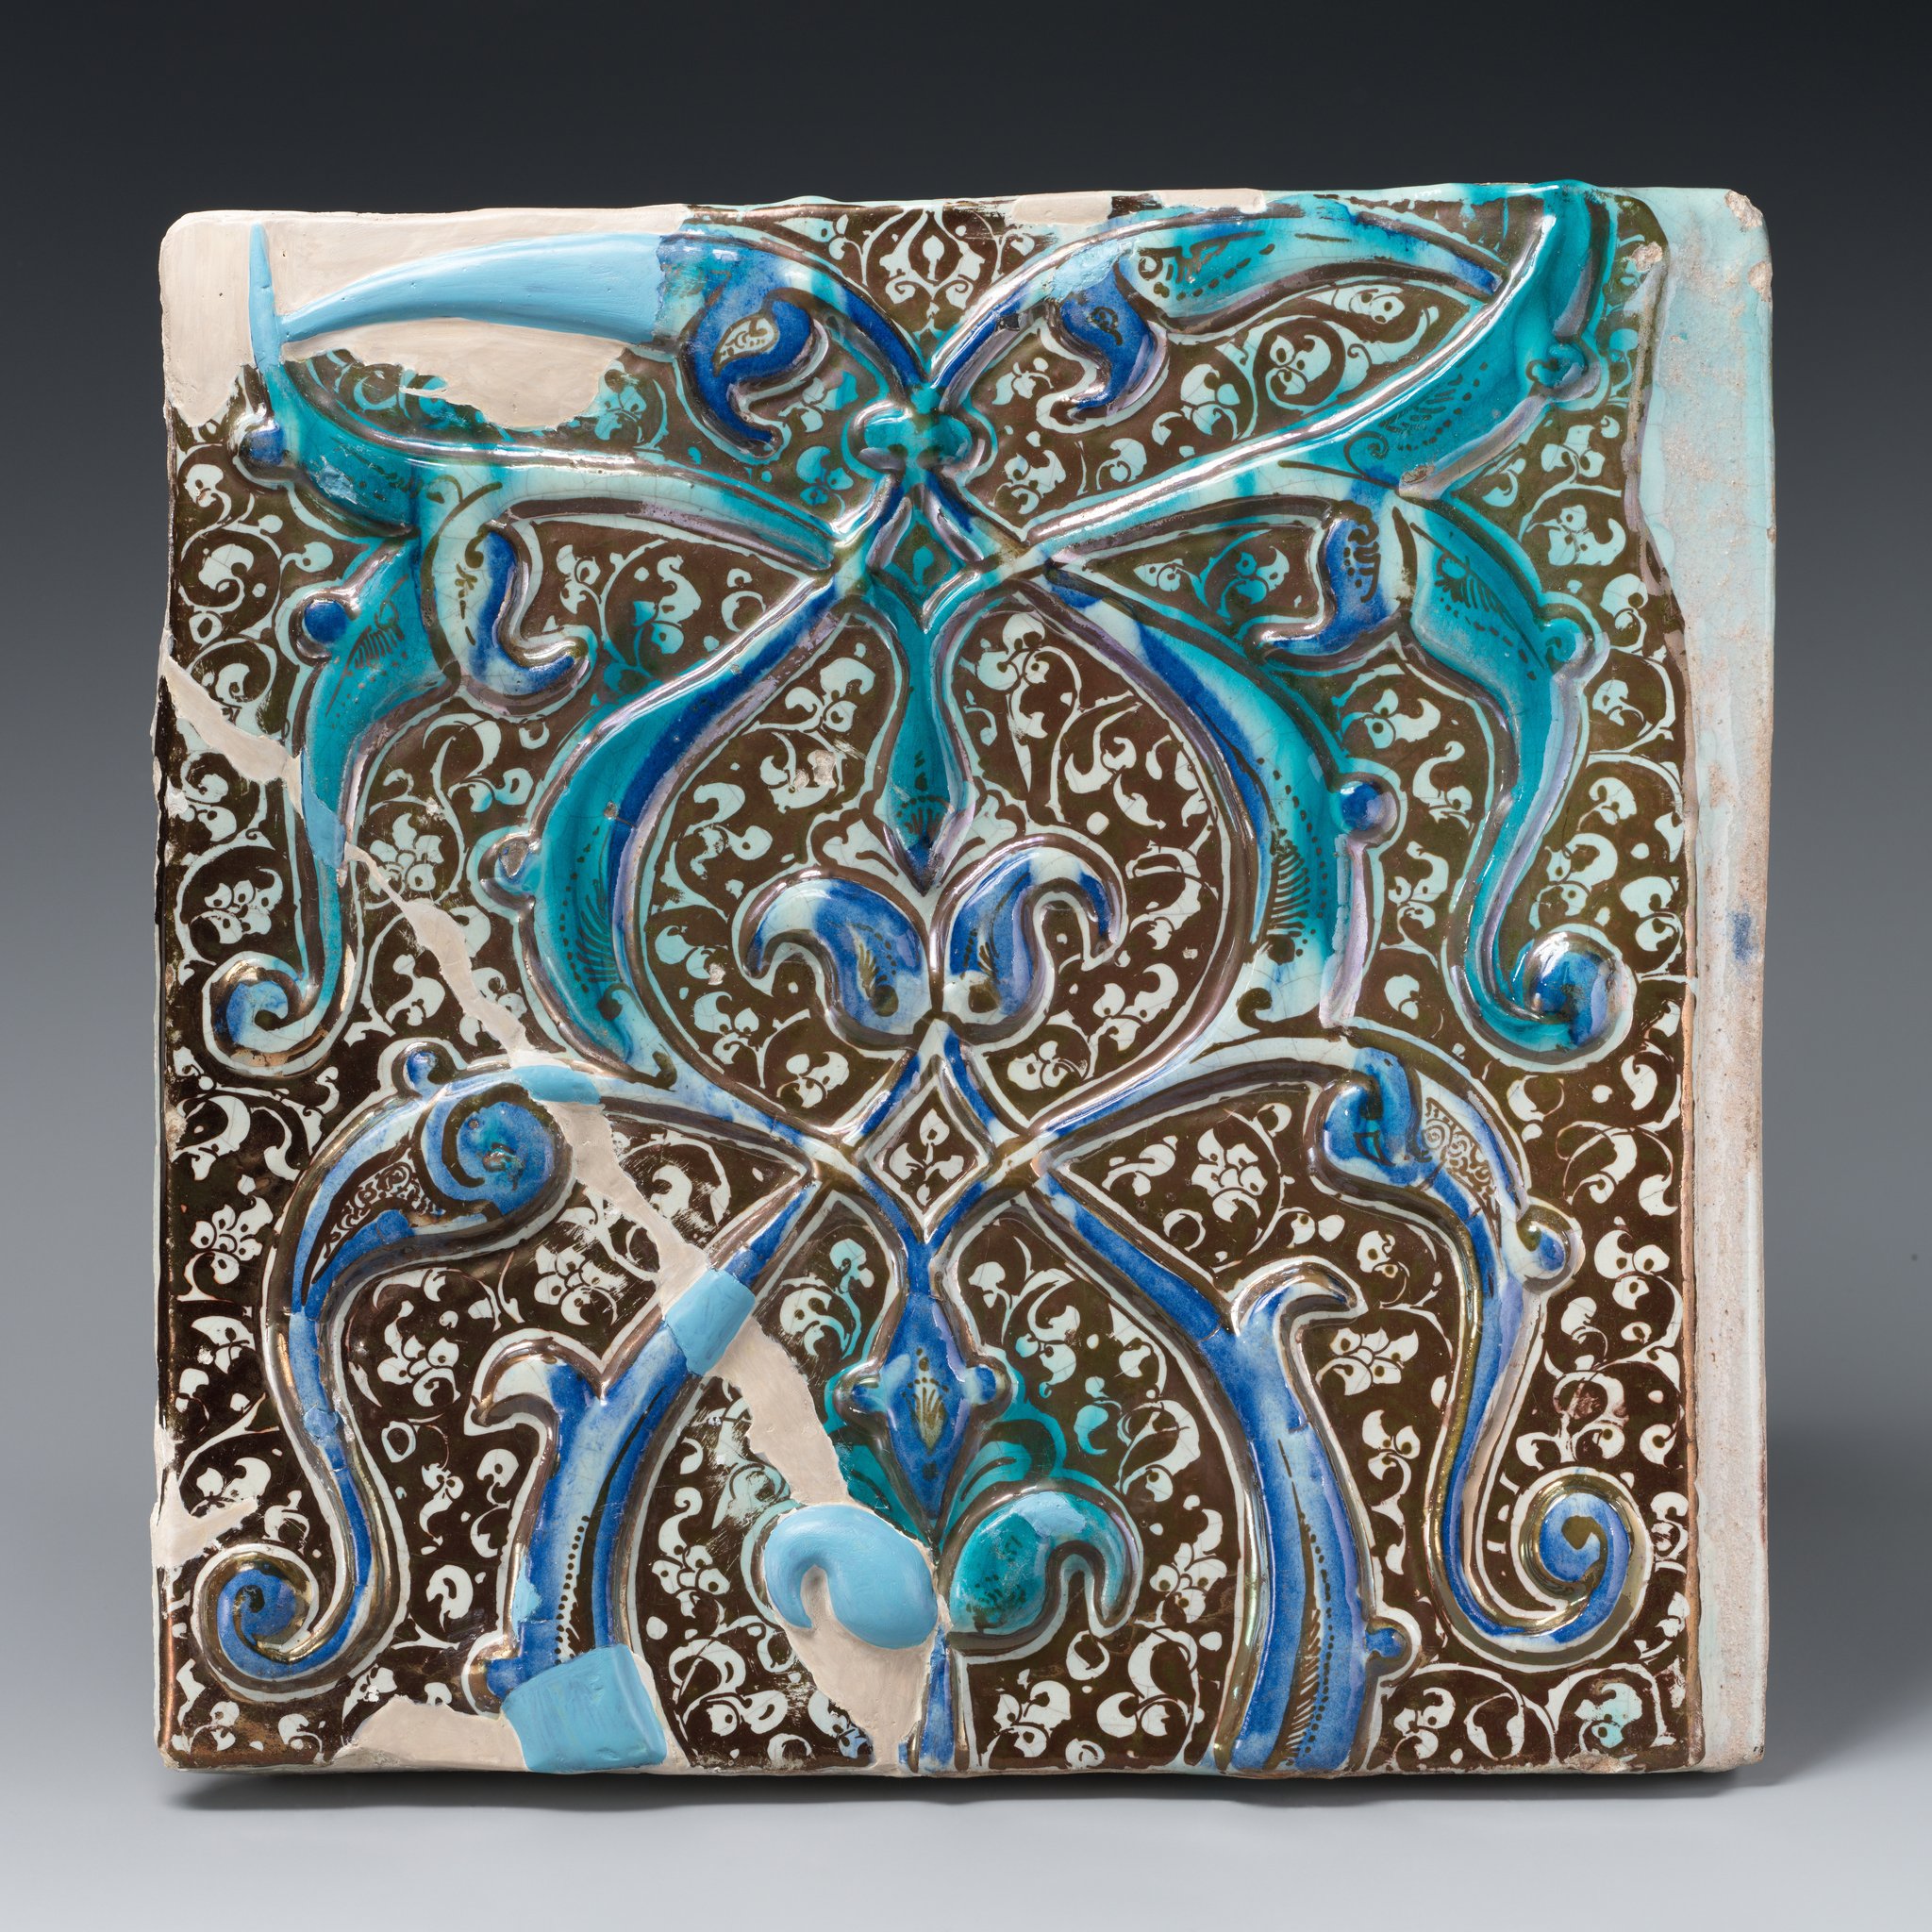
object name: tile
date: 1251-1300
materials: stonepaste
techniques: luster painting, molding, overglaze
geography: iran